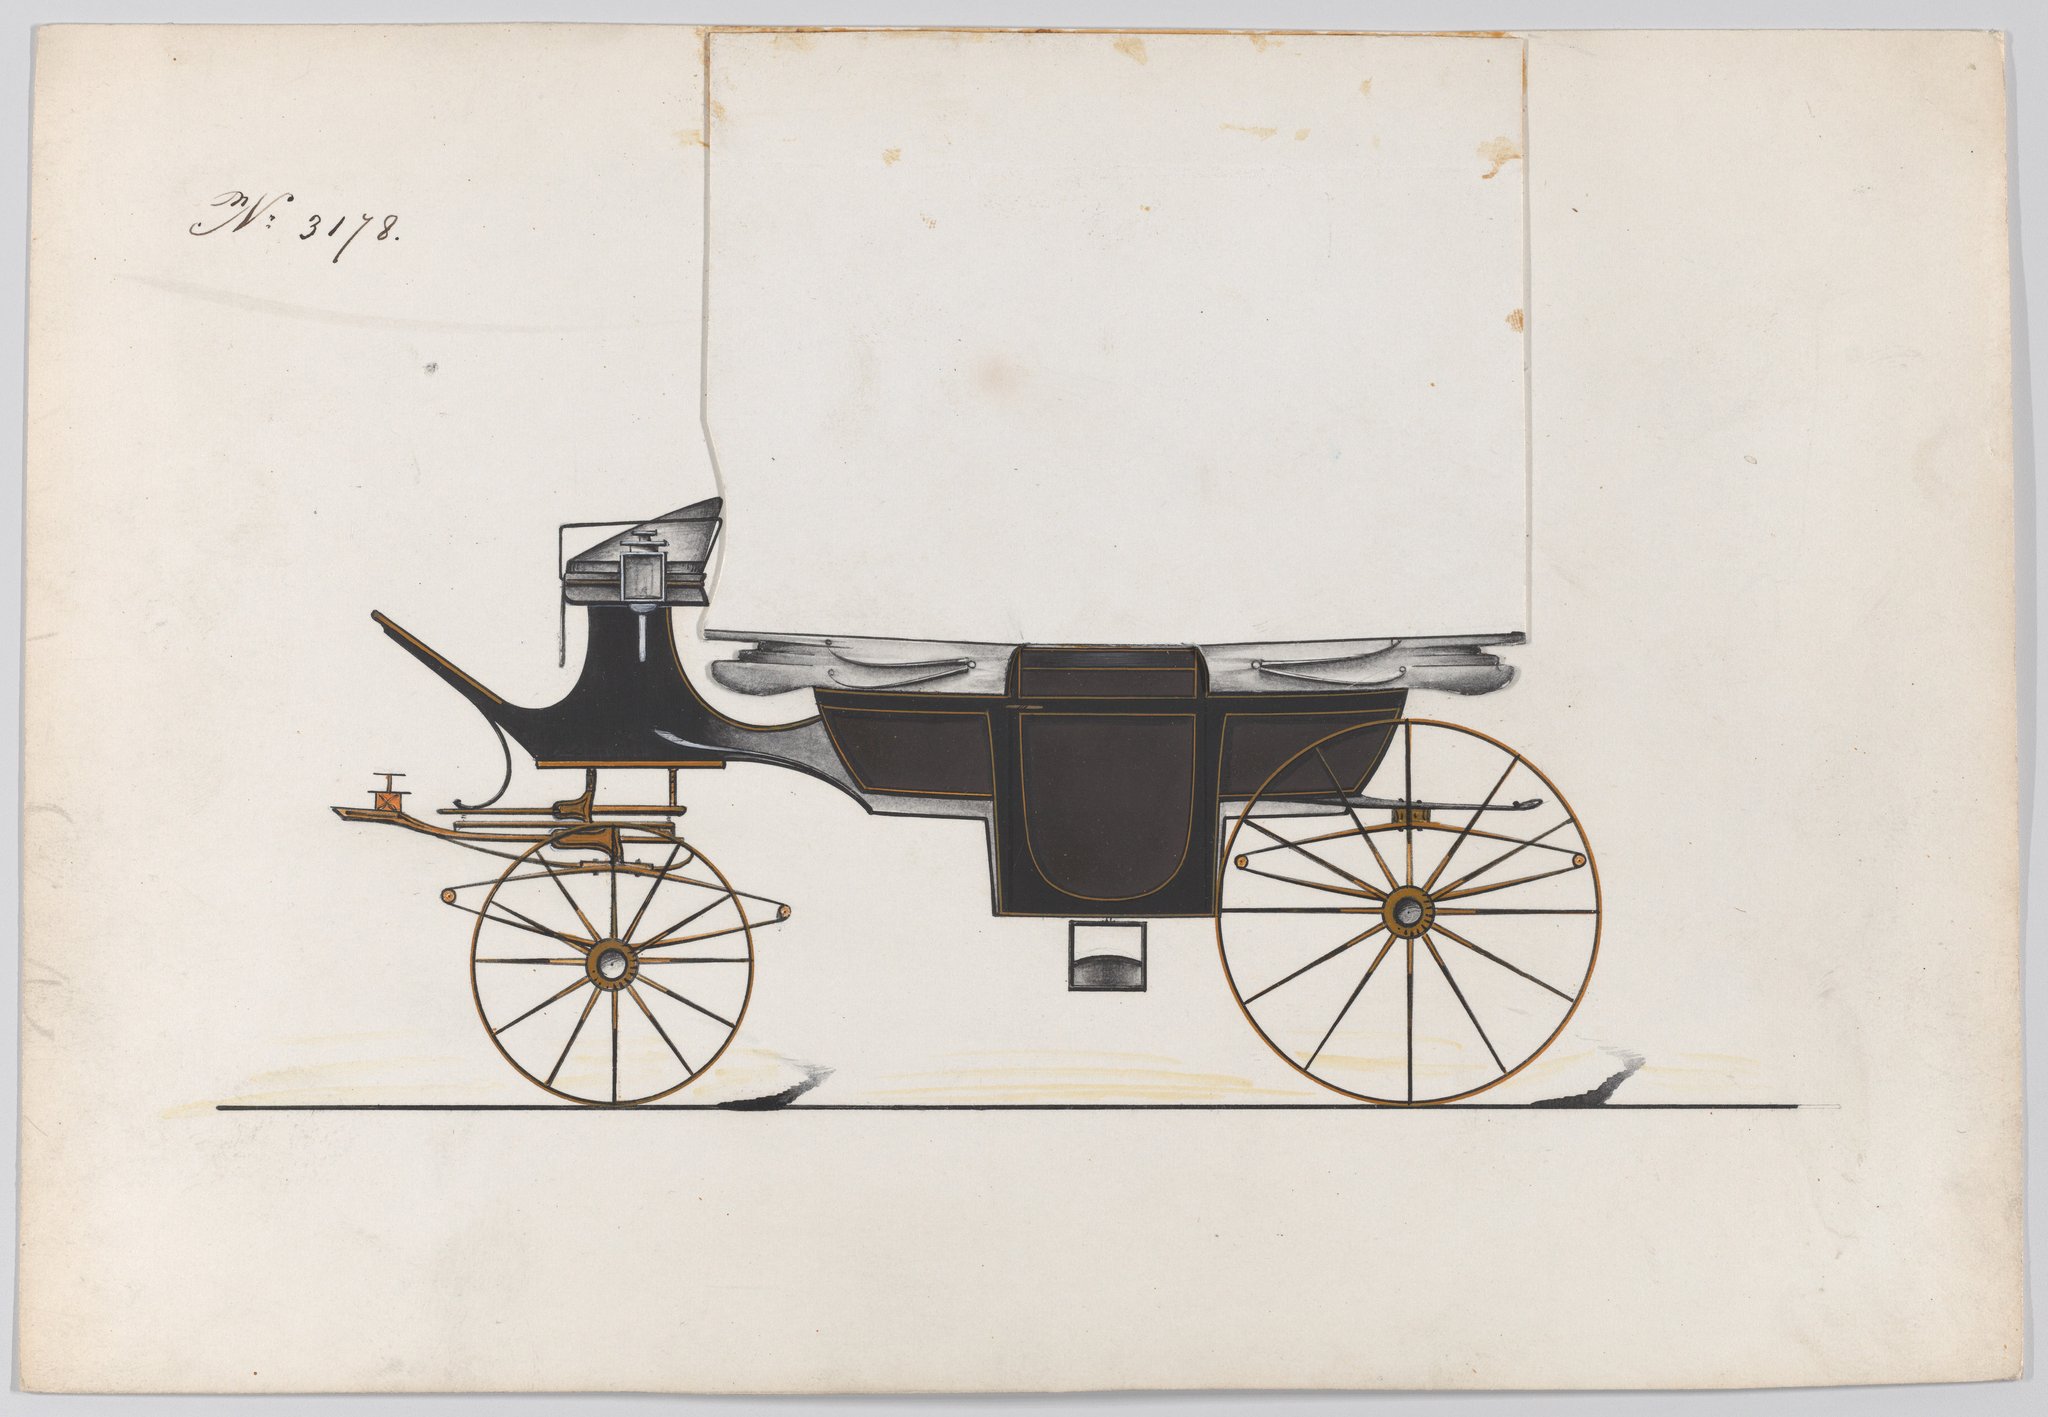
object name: drawing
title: Design for Landau, No. 3178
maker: brewster & co.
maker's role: manufacturer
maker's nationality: american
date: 1875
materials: gouache, gum arabic, ink, watercolor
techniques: pen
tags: carriages